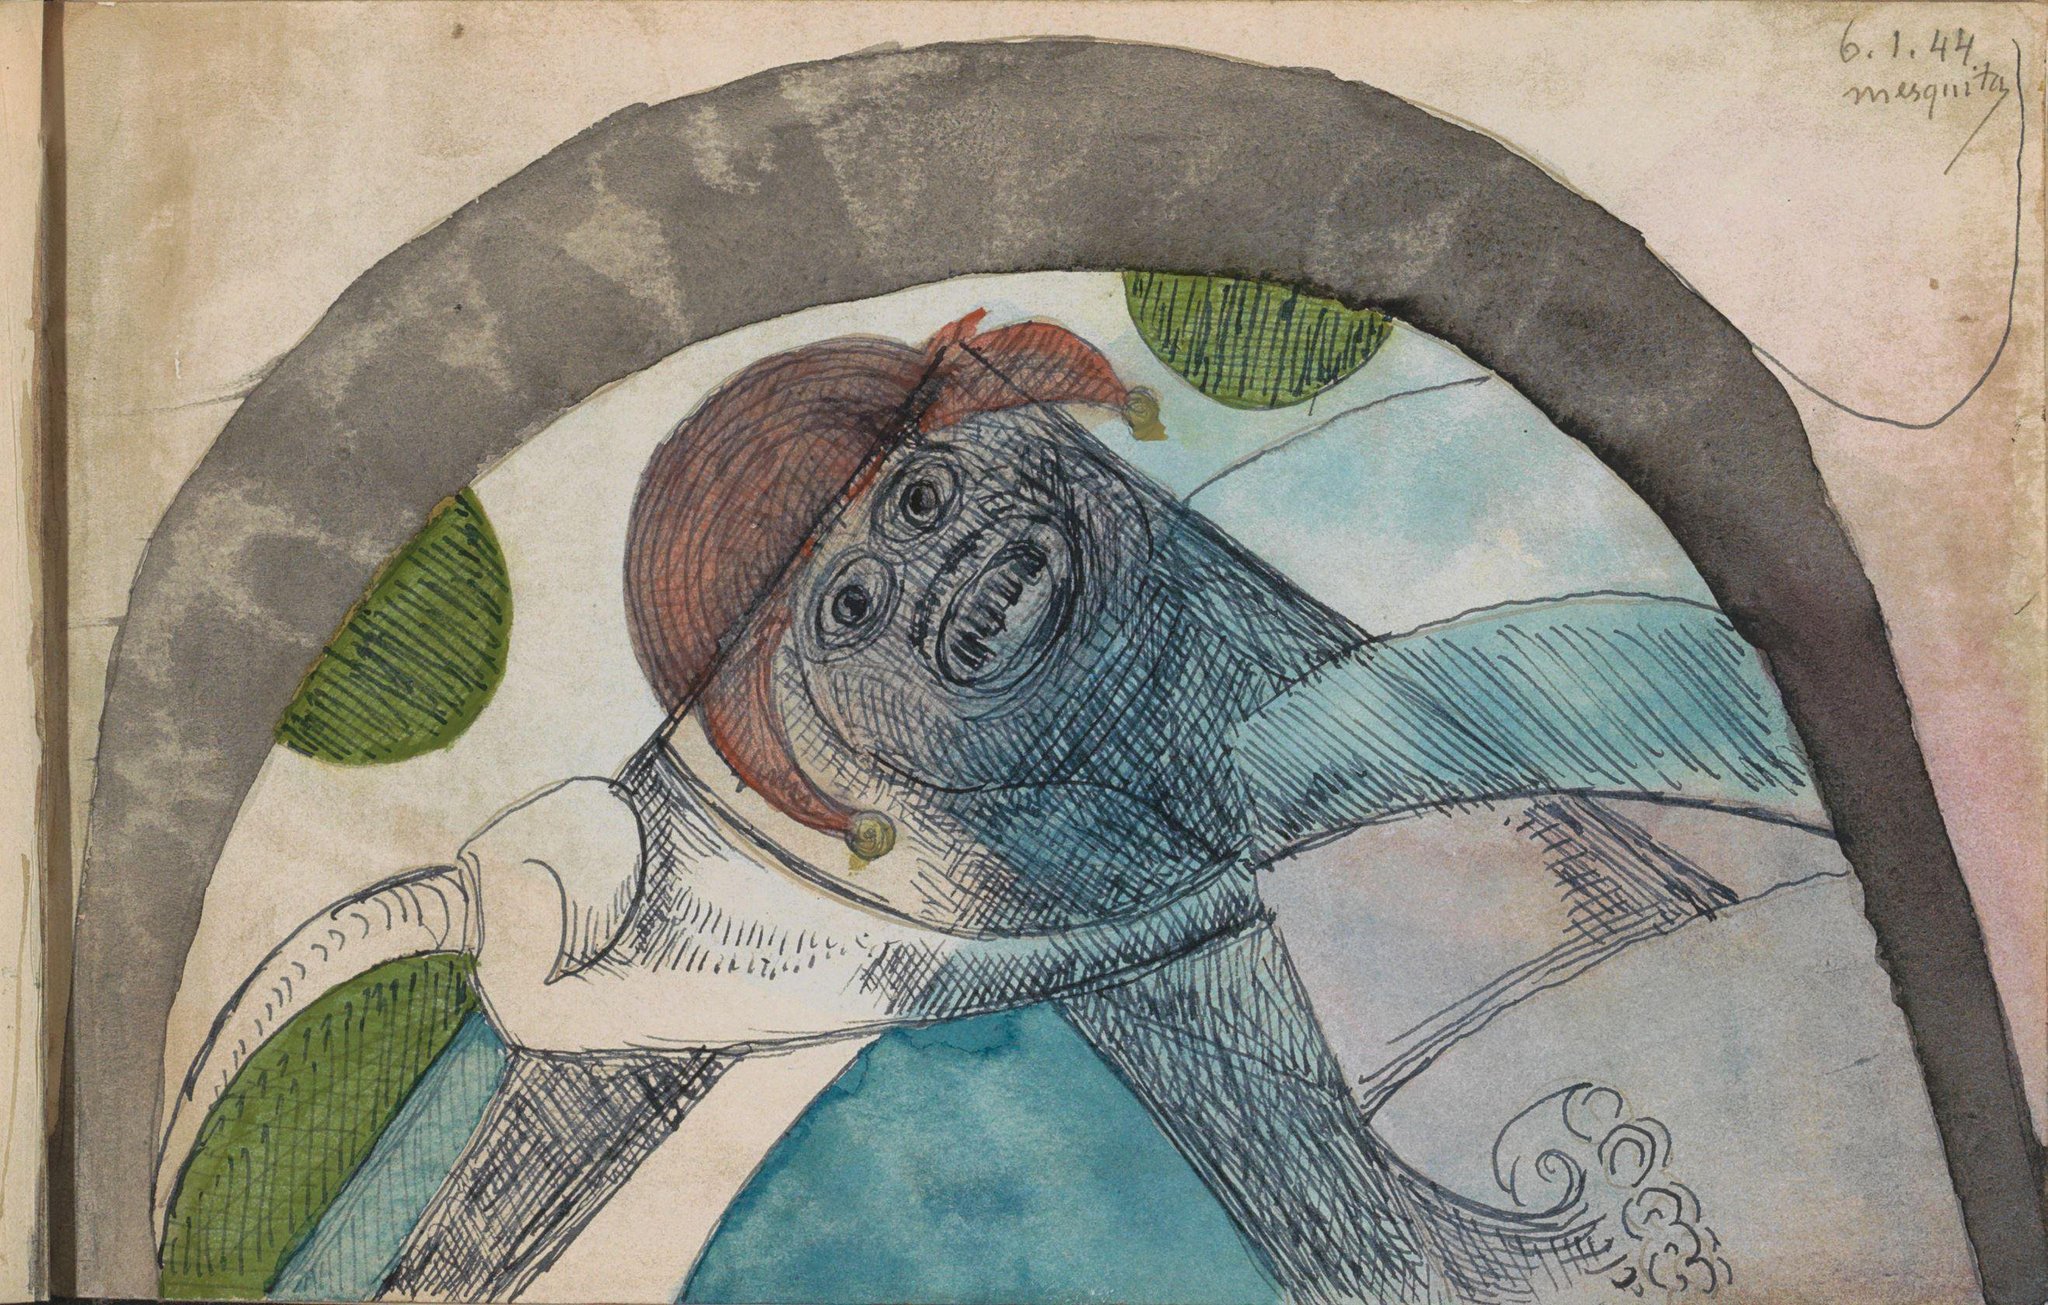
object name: sketchbook leaf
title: Antropomorf figuur met een harlekijnsmuts onder een boog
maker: samuel jessurun de mesquita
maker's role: draughtsman, print maker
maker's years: 1868-1944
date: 1944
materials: ink, paper, watercolor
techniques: brush, pen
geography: amsterdam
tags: anthropomorphic beings with parts missing, arch, archivolt ~ architecture, head-gear: hat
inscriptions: signature and date: ‘6.1.44/ mesquita’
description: Blad 13 recto uit een schetsboek met 18 bladen.